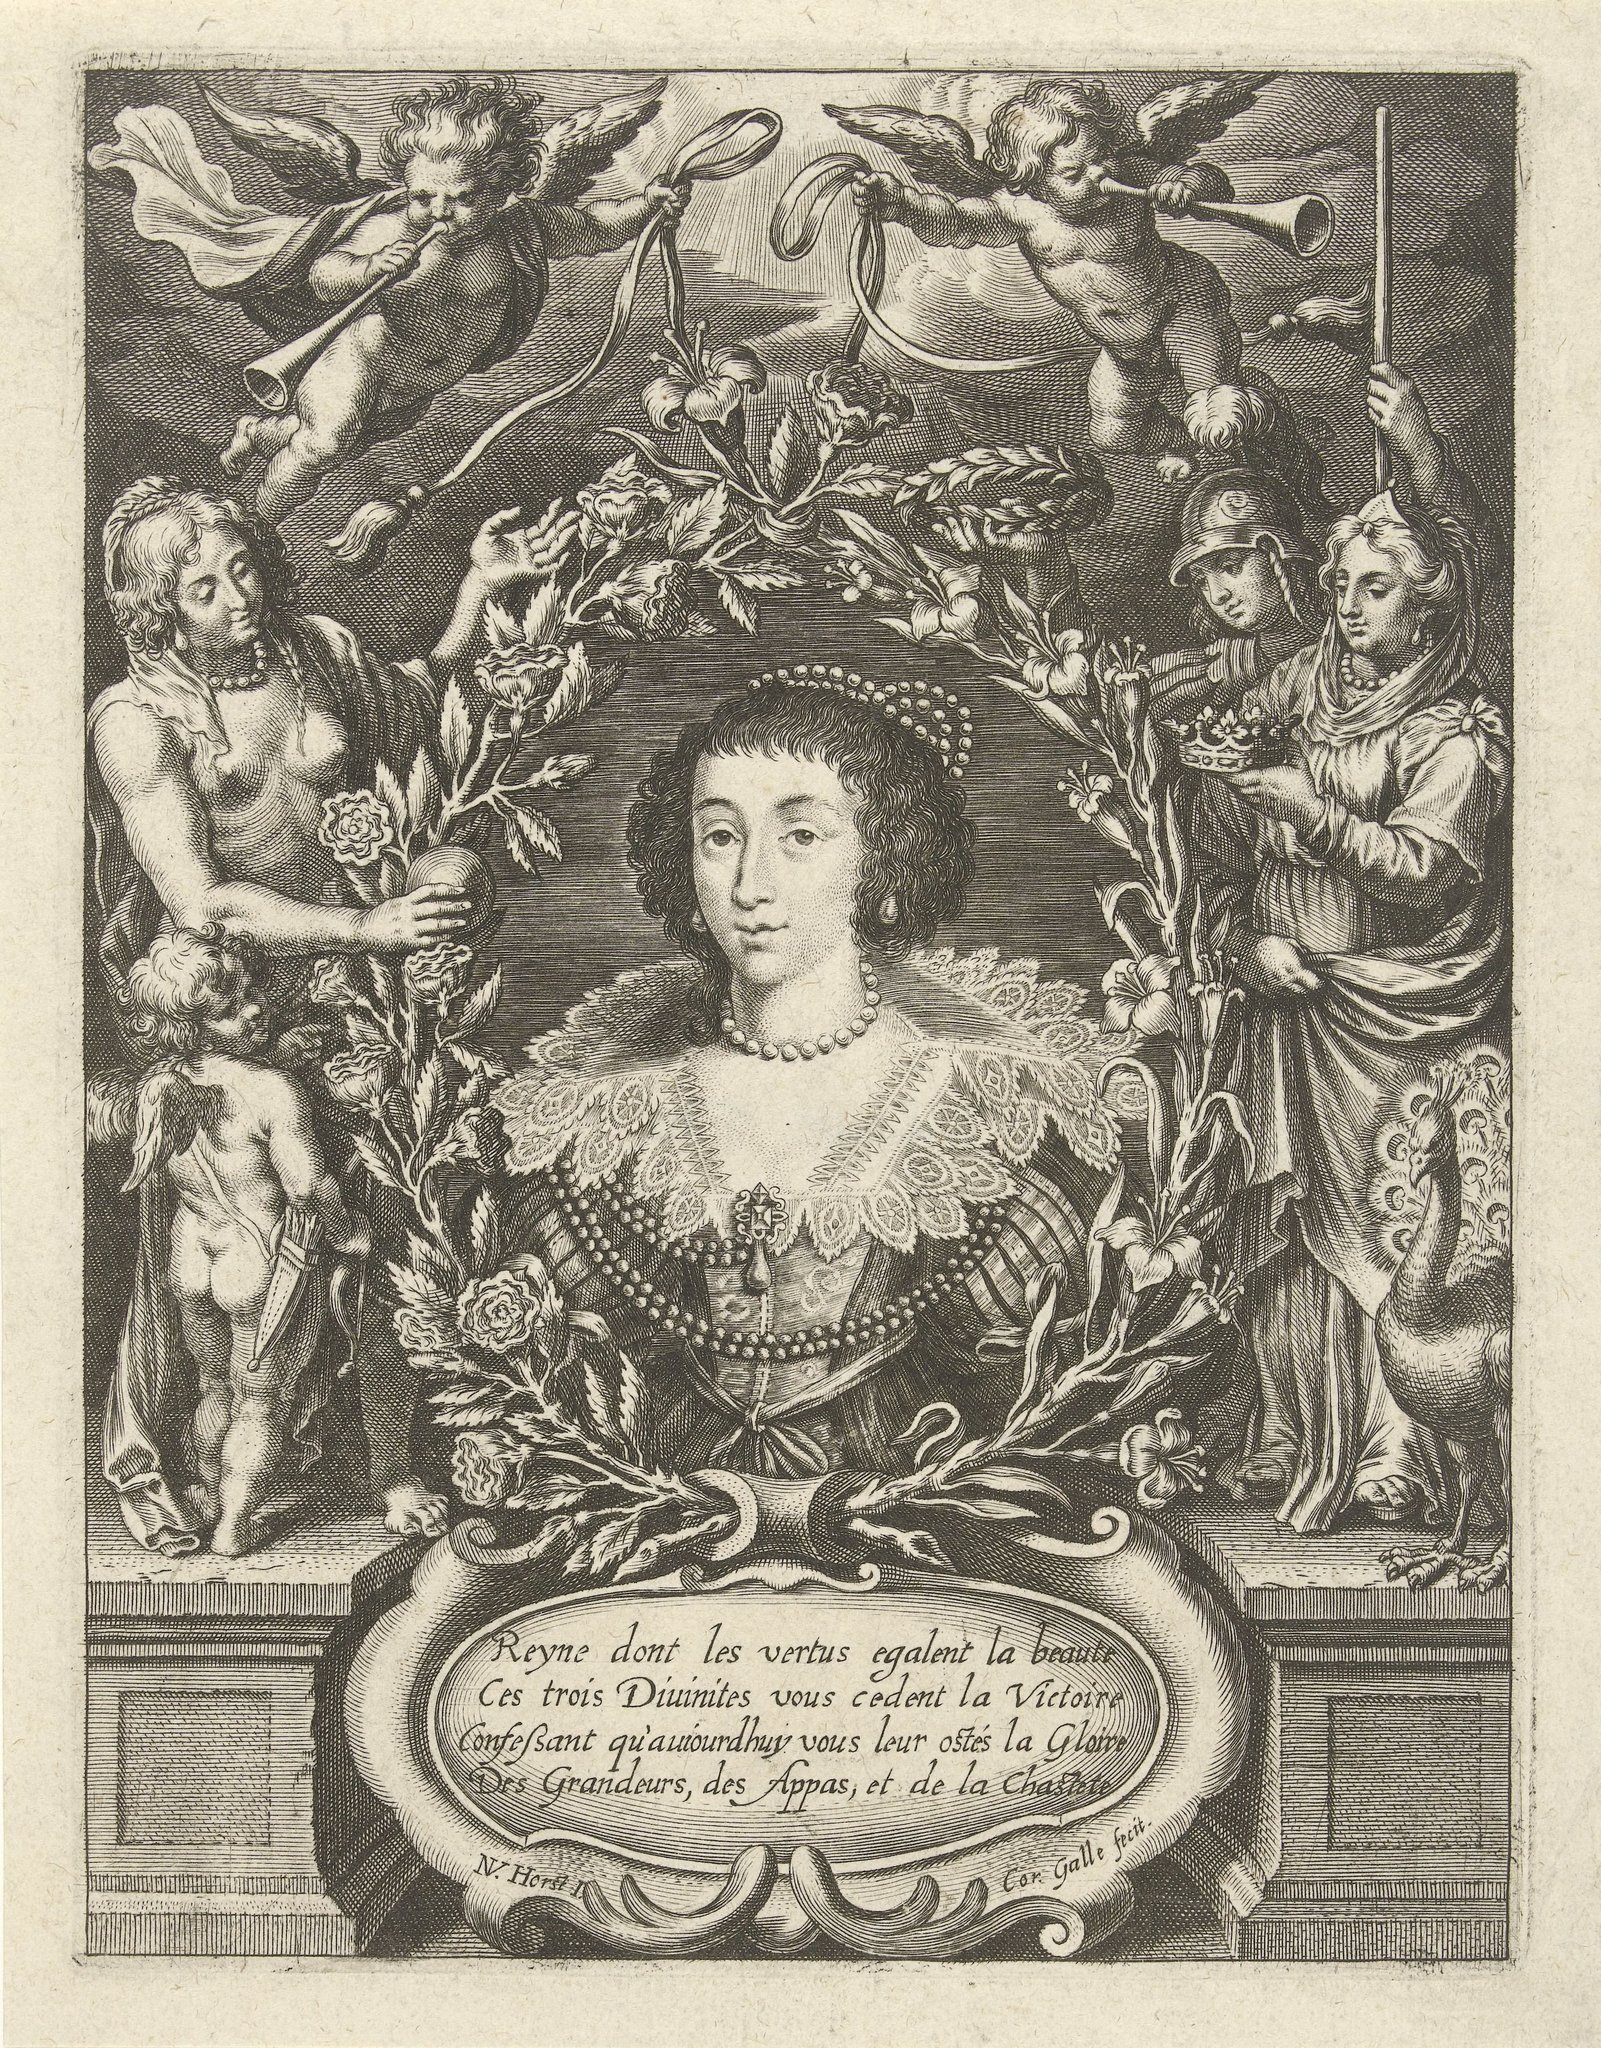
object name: print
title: Portret van Henrietta Maria van Bourbon, koningin van Engeland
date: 1625-1649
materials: paper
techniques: engraving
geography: southern netherlands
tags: henriëtta maria van frankrijk (koningin van engeland, schotland en ierland), (story of) juno (hera), (story of) minerva (pallas, athena), venus and cupid (cupid not being mere attribute)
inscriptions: collector's mark: Lugt 2228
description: Portret van Henrietta Maria van Bourbon, koningin van Engeland met Venus en Amor, Juno en Minerva. Boven het portret blazen twee engelen op bazuinen.